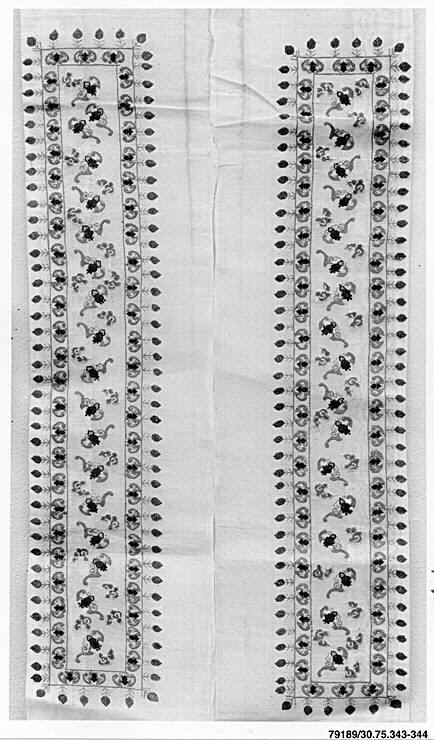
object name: sleeve band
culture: chinese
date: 1801-1900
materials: silk